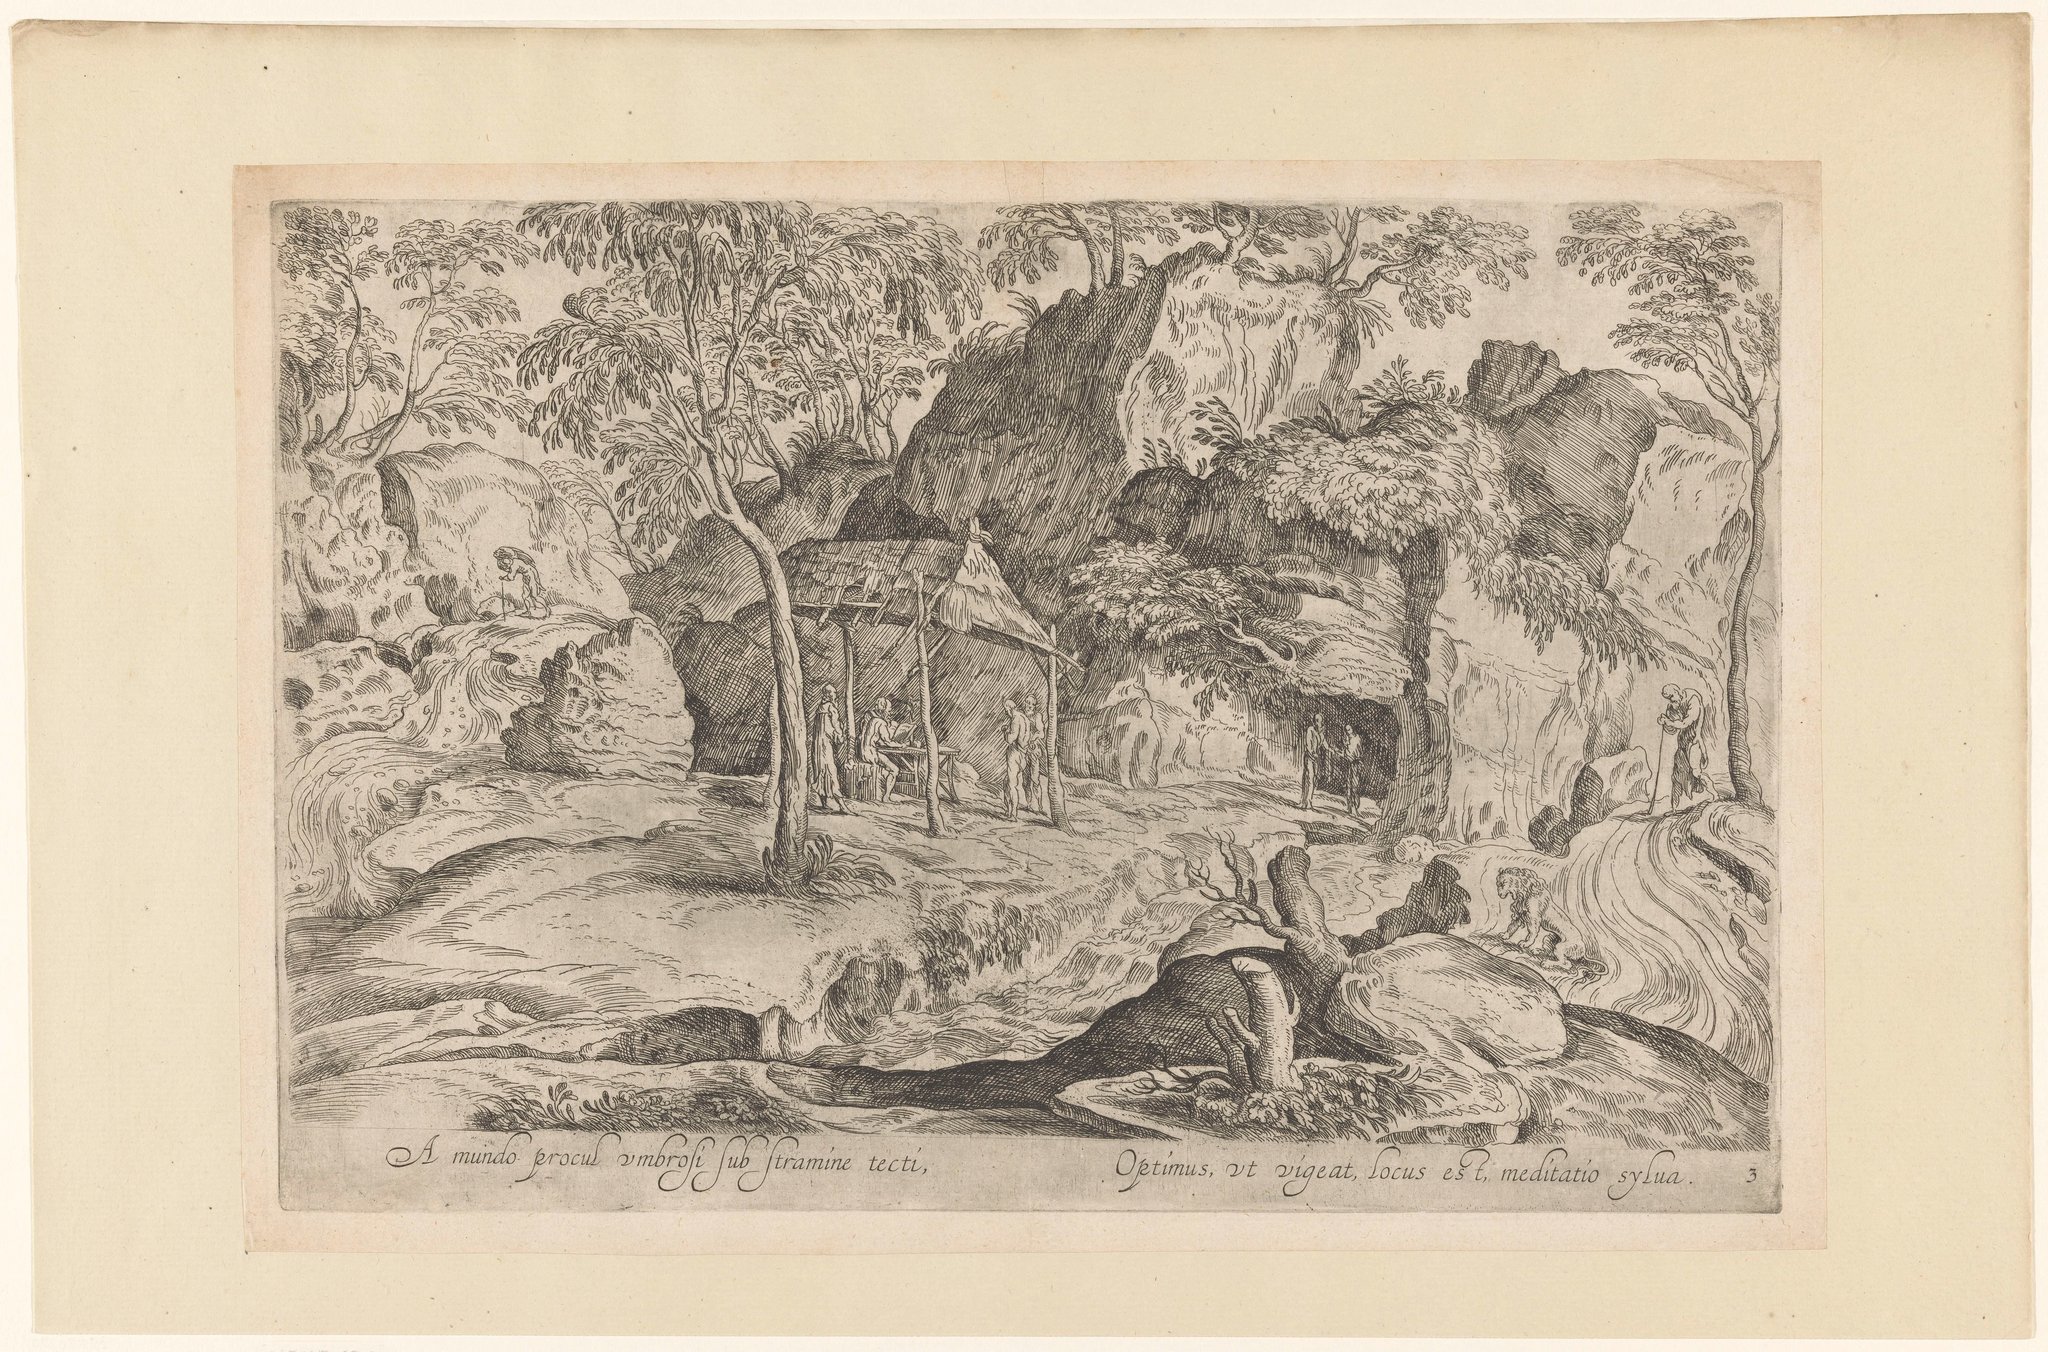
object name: print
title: Landschappen naar Domenico Campagnola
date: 1600-1699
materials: paper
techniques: etching, intaglio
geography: italy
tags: landscapes, beasts of prey, predatory animals: lion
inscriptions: collector's mark: Lugt 2228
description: Rotsachtig landschap met centraal een dak op palen, waaronder mannen bidden voor een crucifix. Rechts een brullende leeuw. Titel in het Latijn in ondermarge. Genummerd rechtsonder: 3.